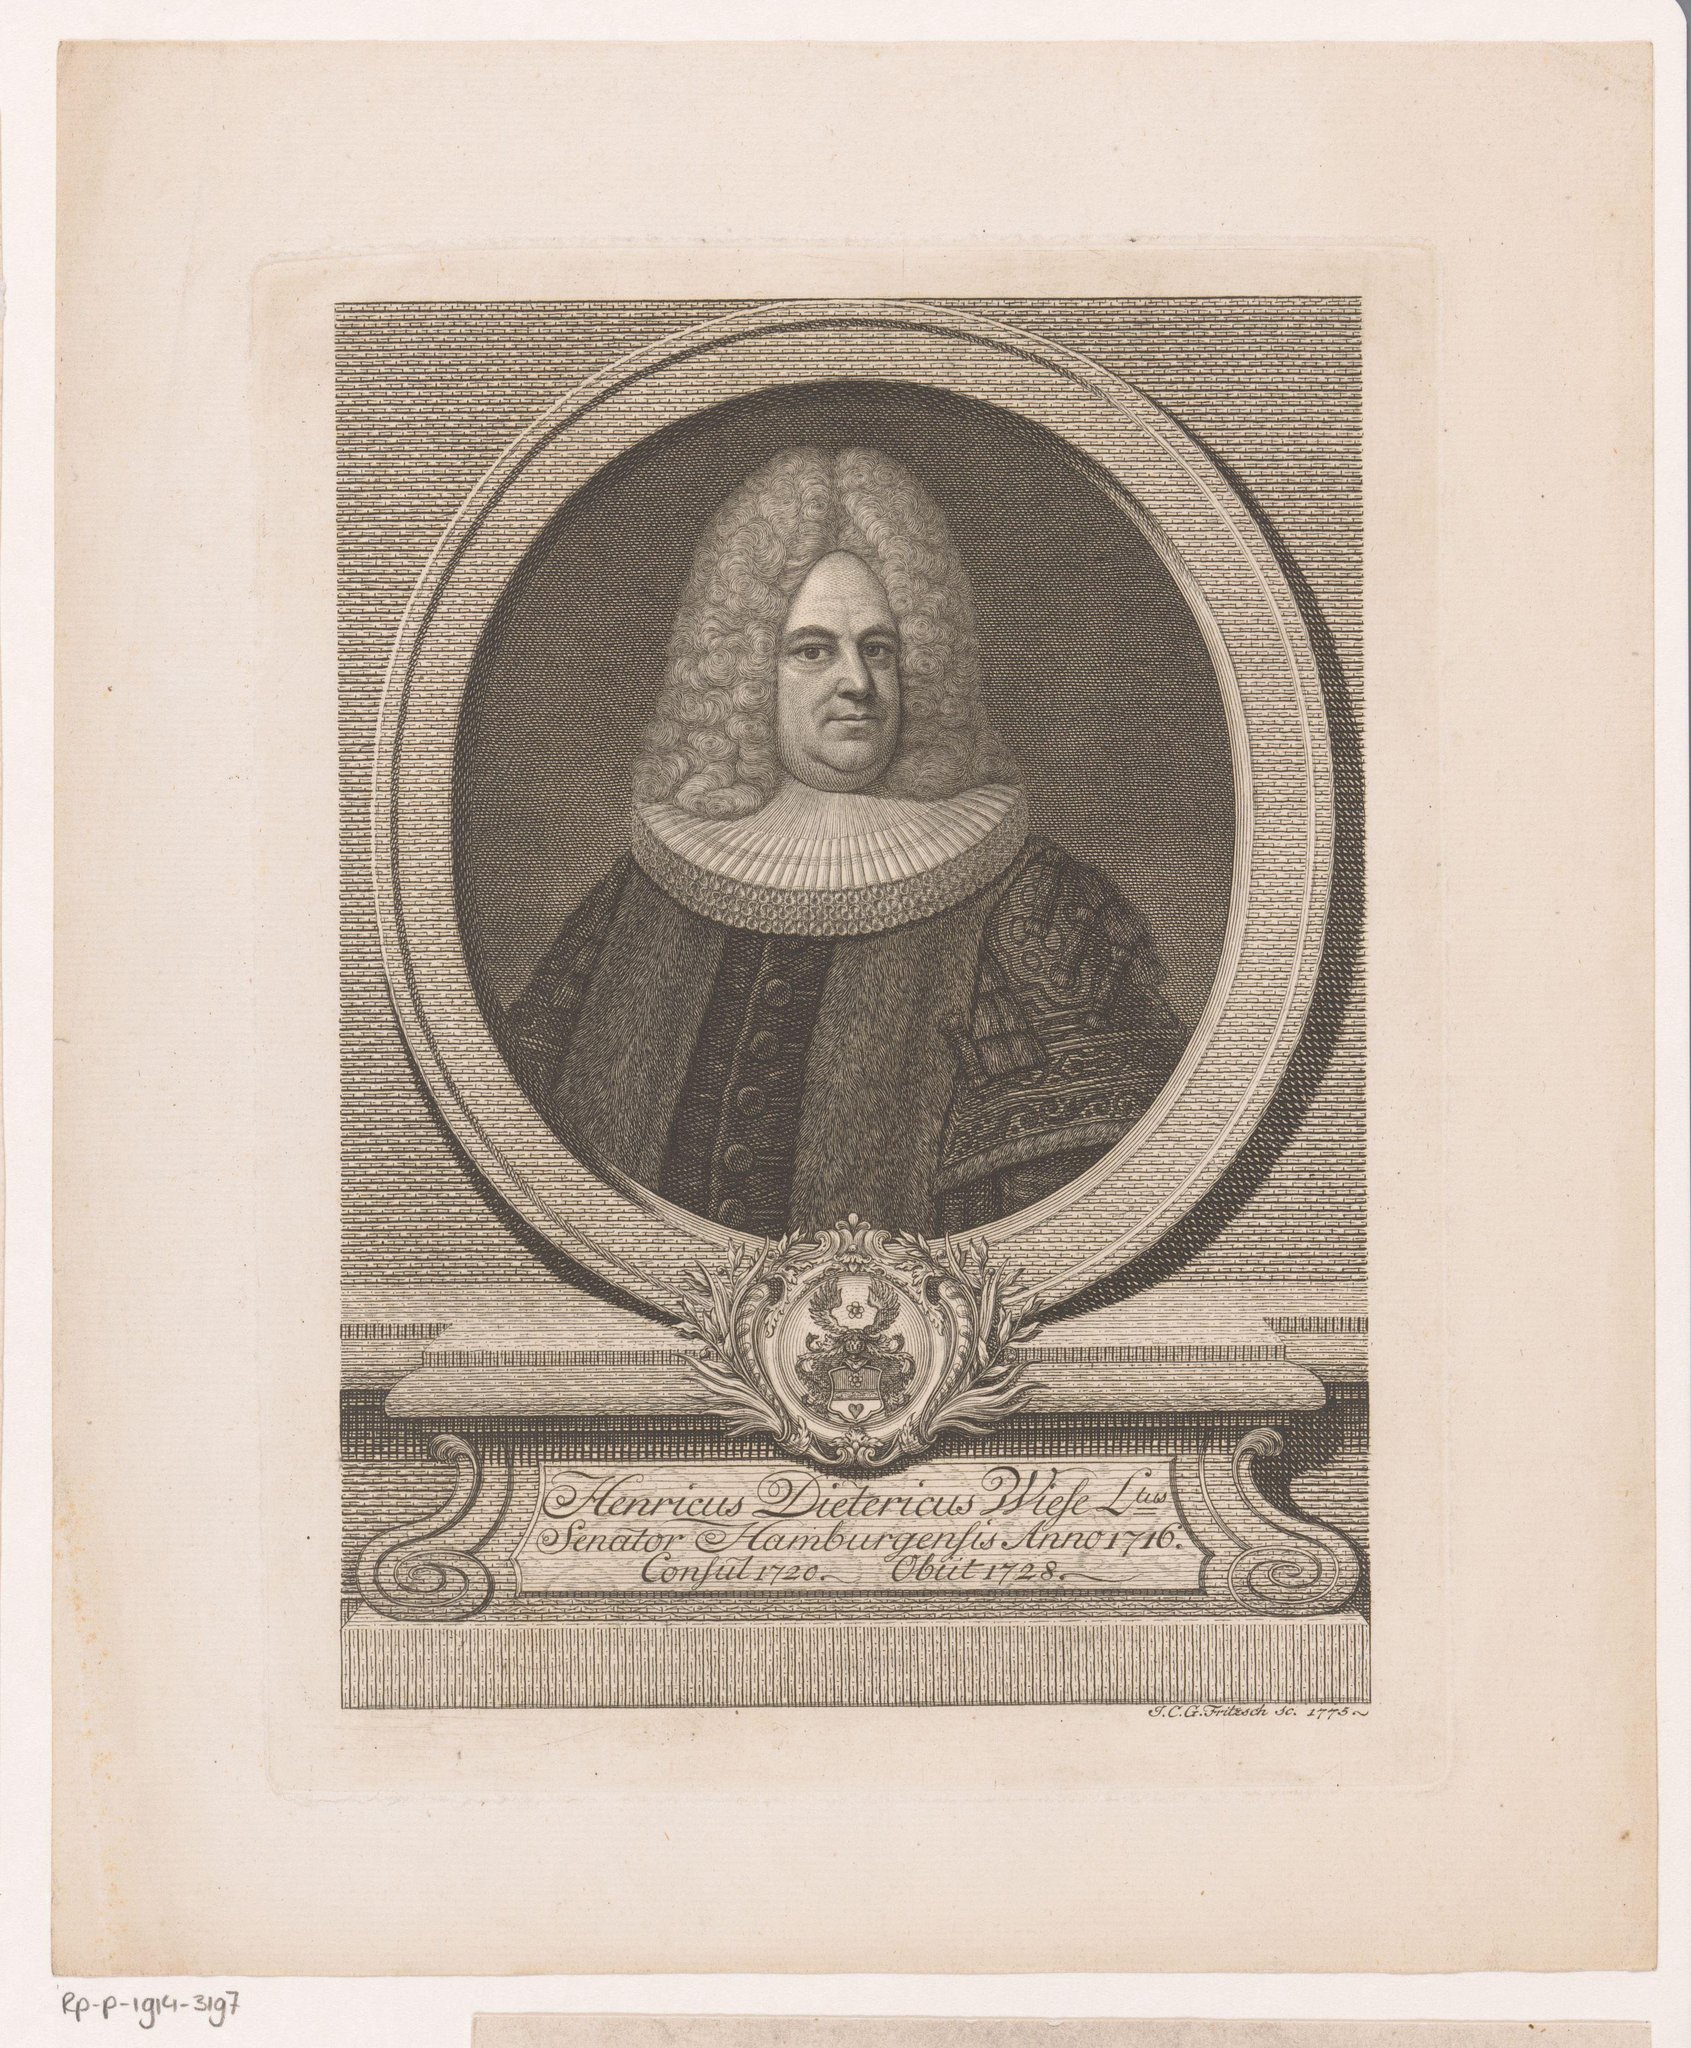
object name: print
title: Portret van Heinrich Dieterich Wiese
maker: johann christian gottfried fritzsch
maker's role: print maker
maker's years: 1720-1802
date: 1775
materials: paper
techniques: engraving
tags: mayor, ornament ~ medallion, historical persons, armorial bearing, heraldry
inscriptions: collector's mark: Lugt 2228